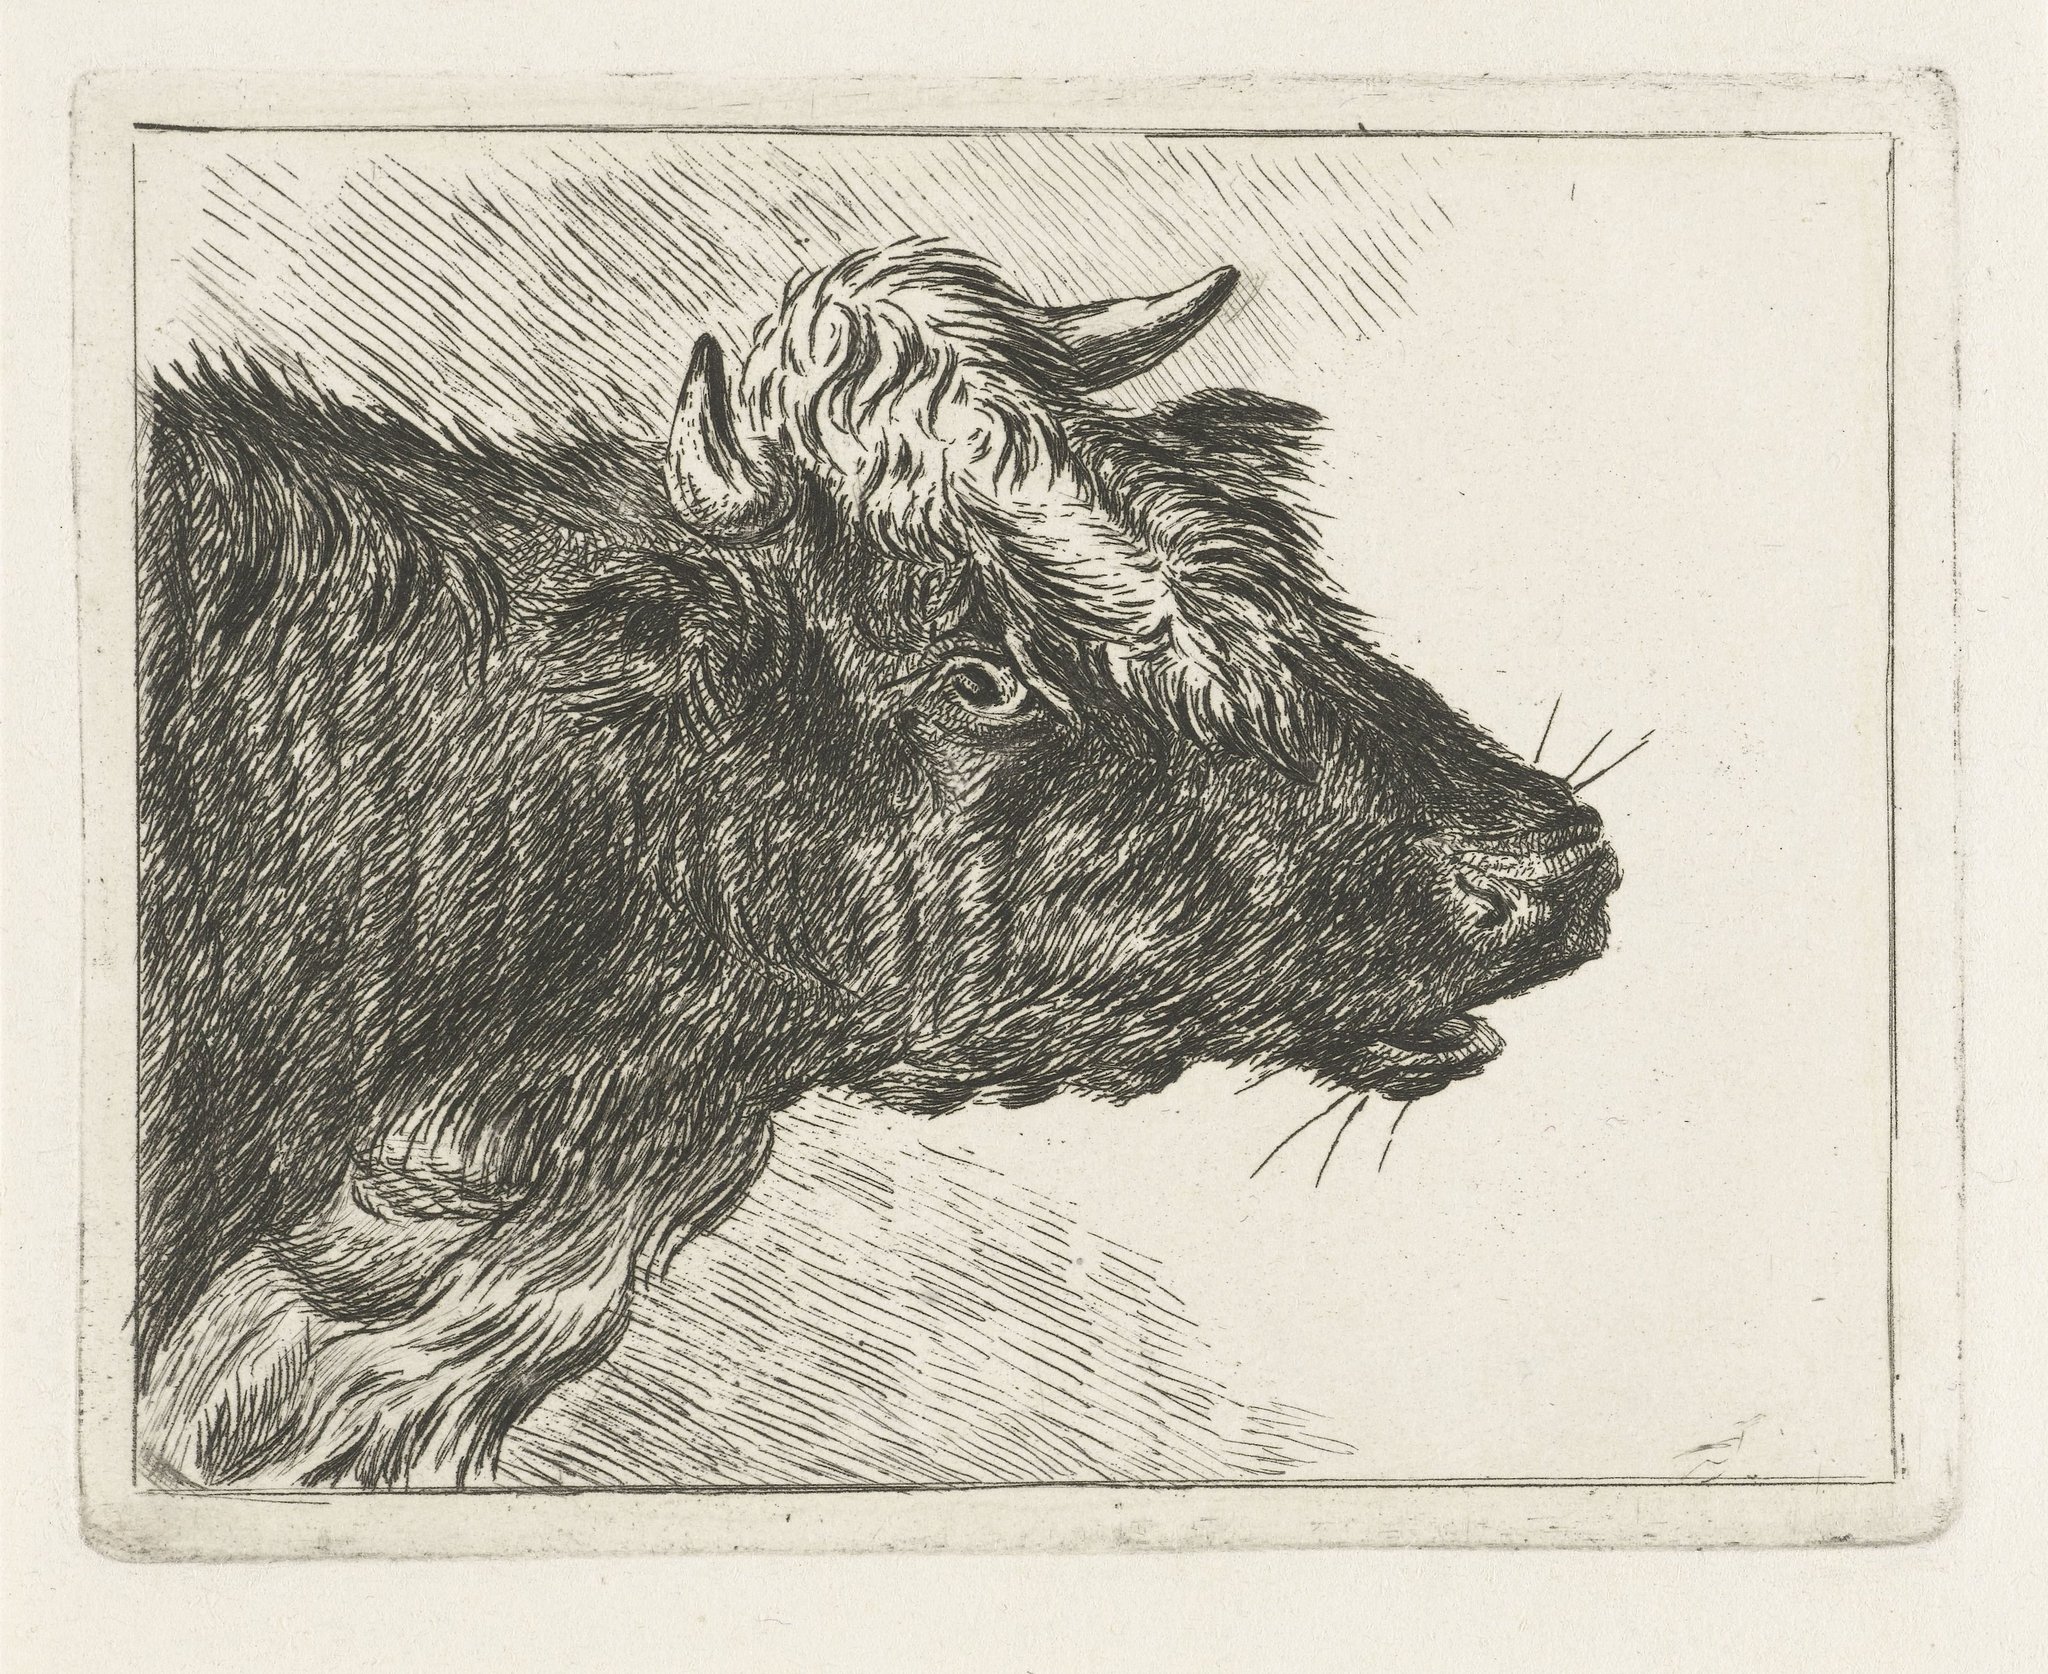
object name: print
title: Loeiende os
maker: jacobus cornelis gaal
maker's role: print maker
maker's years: 1796-1866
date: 1848-1855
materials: paper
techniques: etching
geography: the hague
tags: bull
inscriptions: collector's mark: Lugt 2228